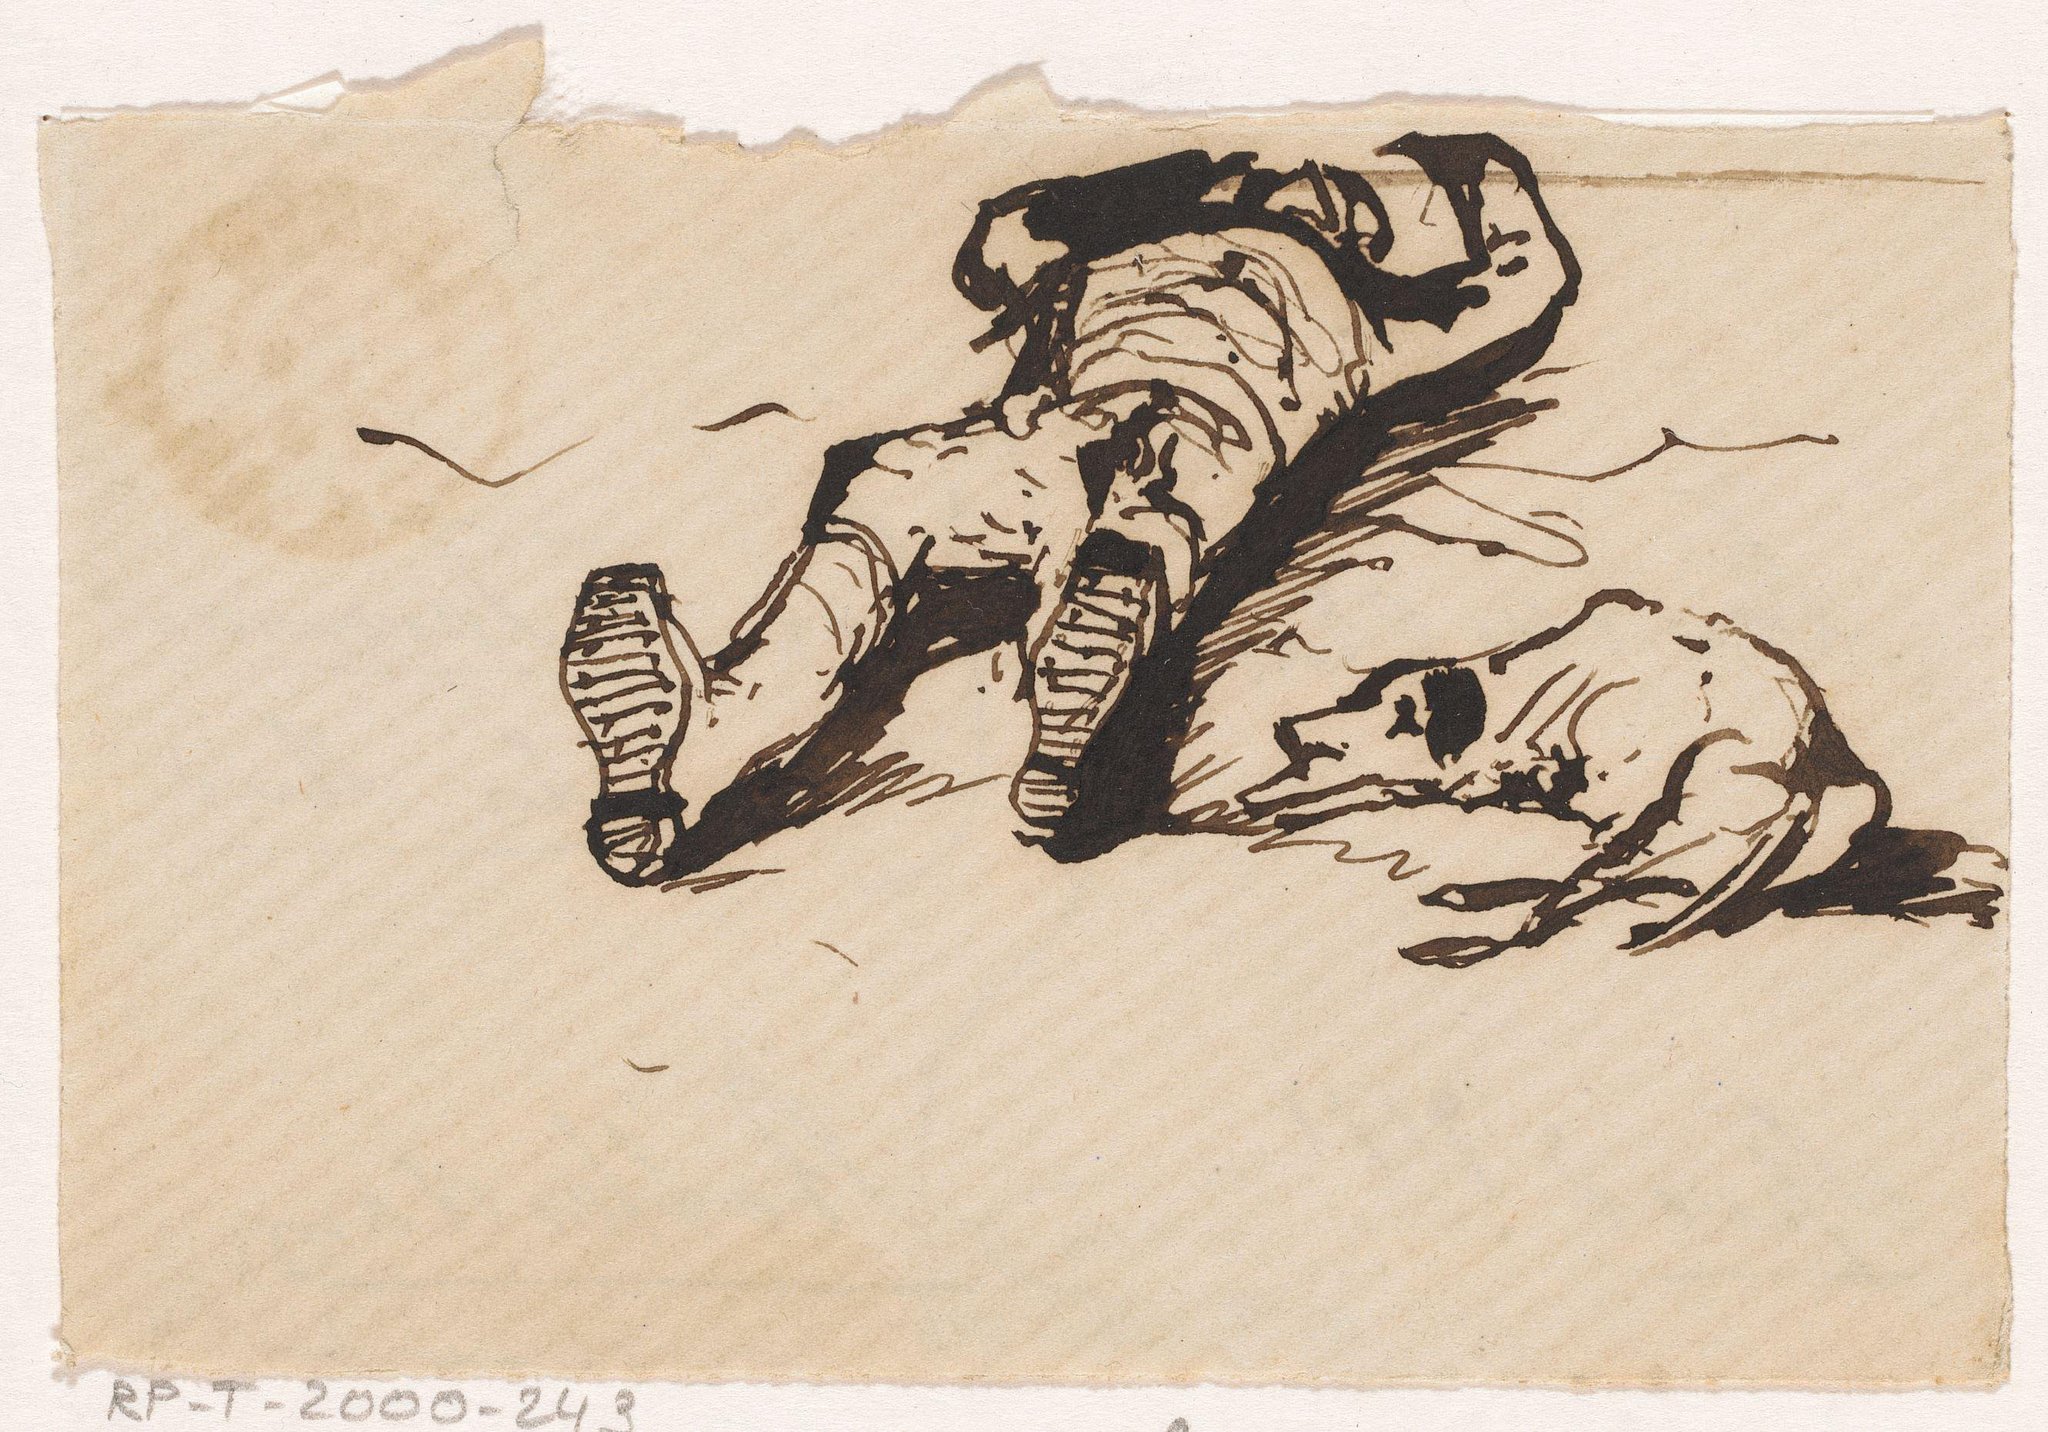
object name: drawing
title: Liggende man met hond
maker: johannes tavenraat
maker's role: draughtsman, painter, print maker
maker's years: 1809-1881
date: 1869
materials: ink, paper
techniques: pen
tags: lying on the back with hands under the head, dog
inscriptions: collector's mark: Lugt 2228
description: Liggende man met hond, getekend op de achterzijde van een envelop geadresseerd aan Tavenraat met poststempel 16 sept. 69.